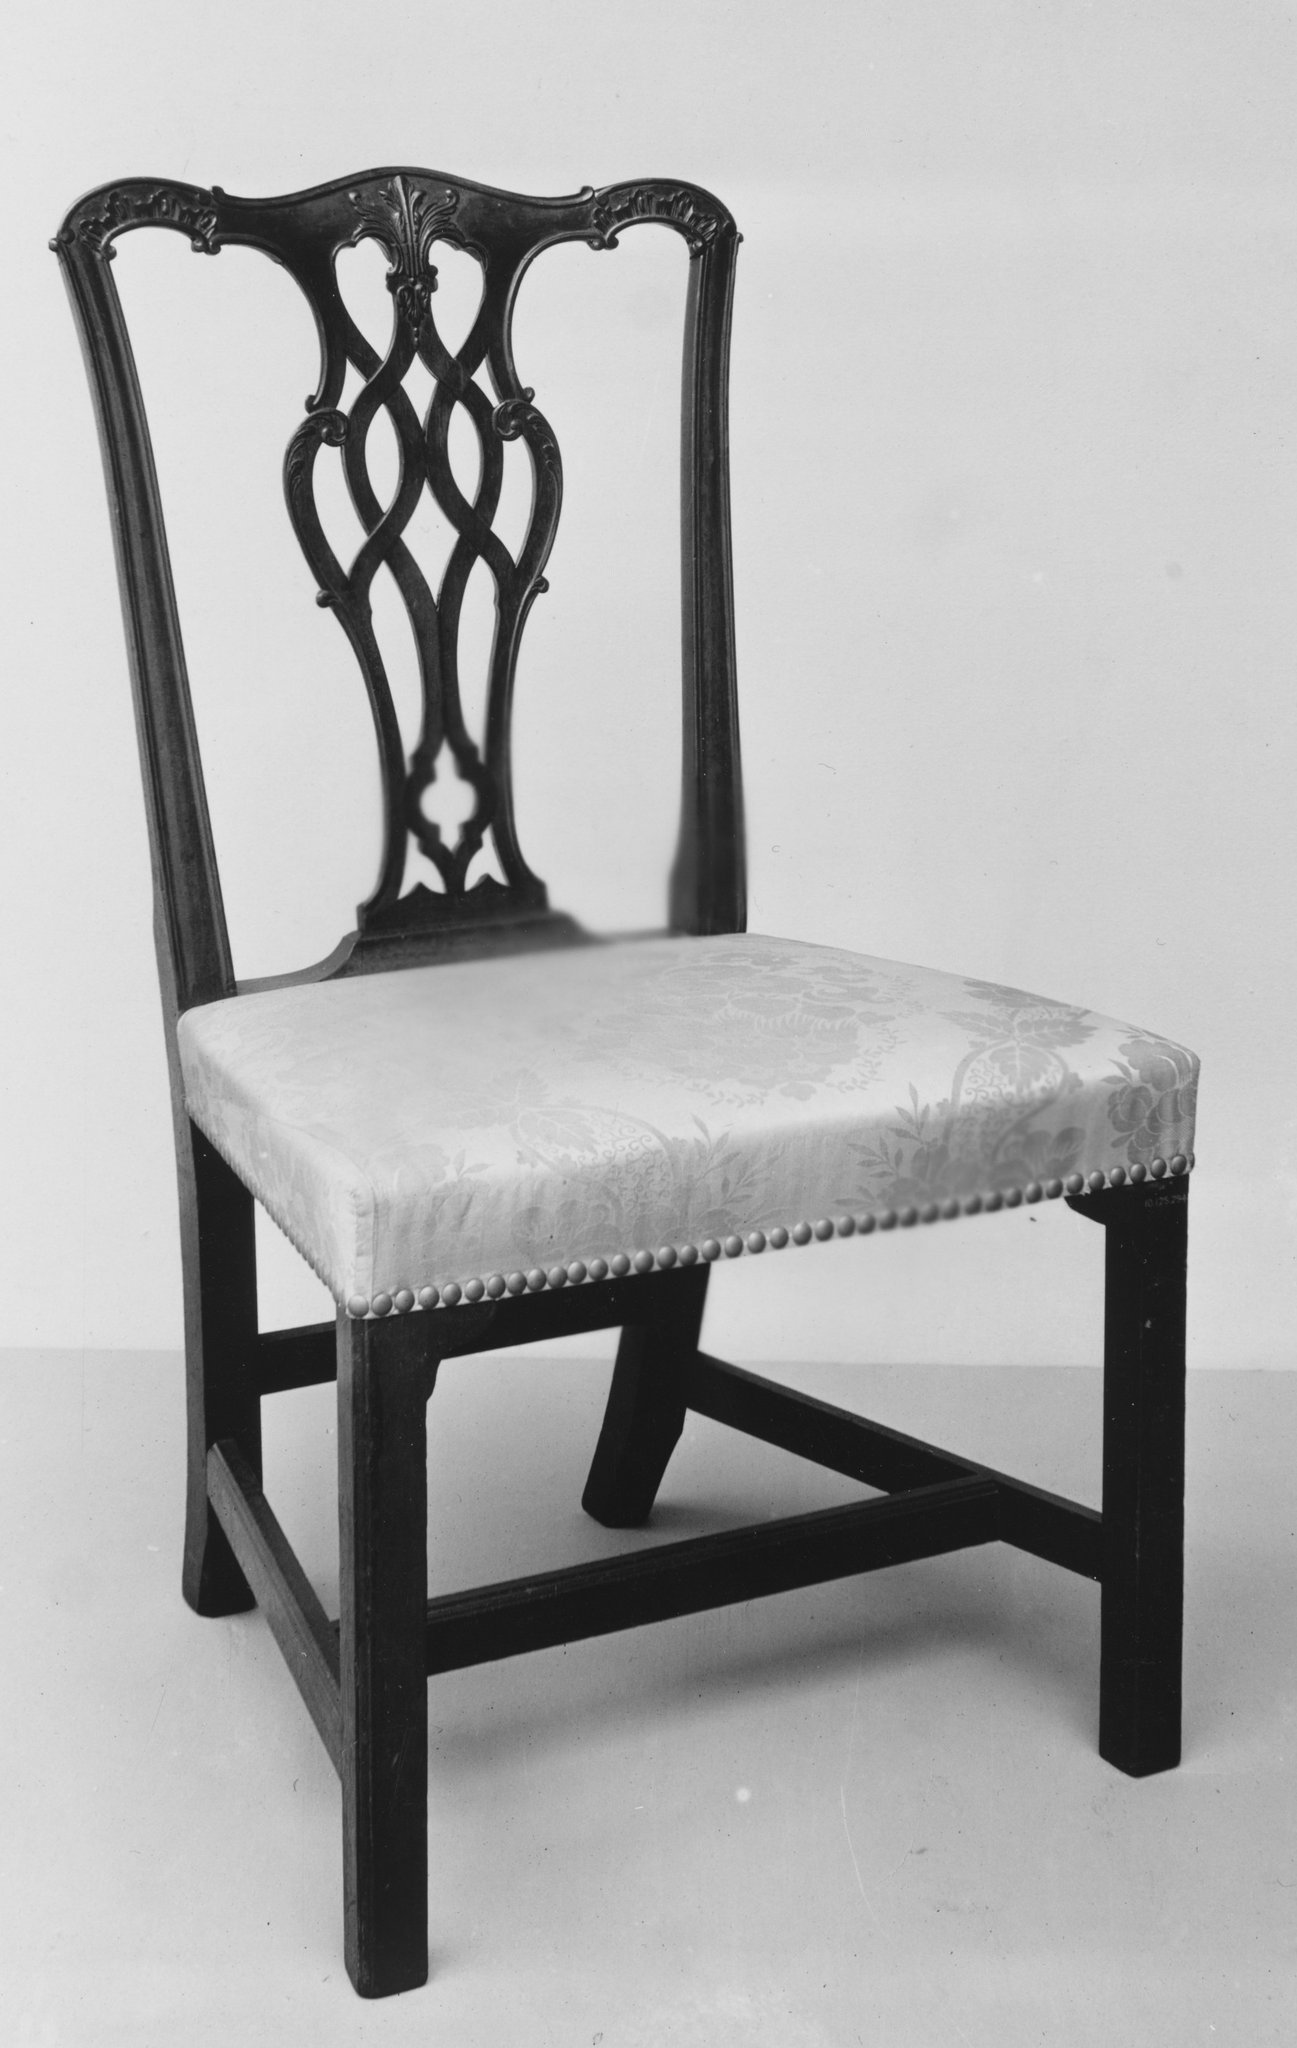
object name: side chair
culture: american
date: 1760-1790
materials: wood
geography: united states